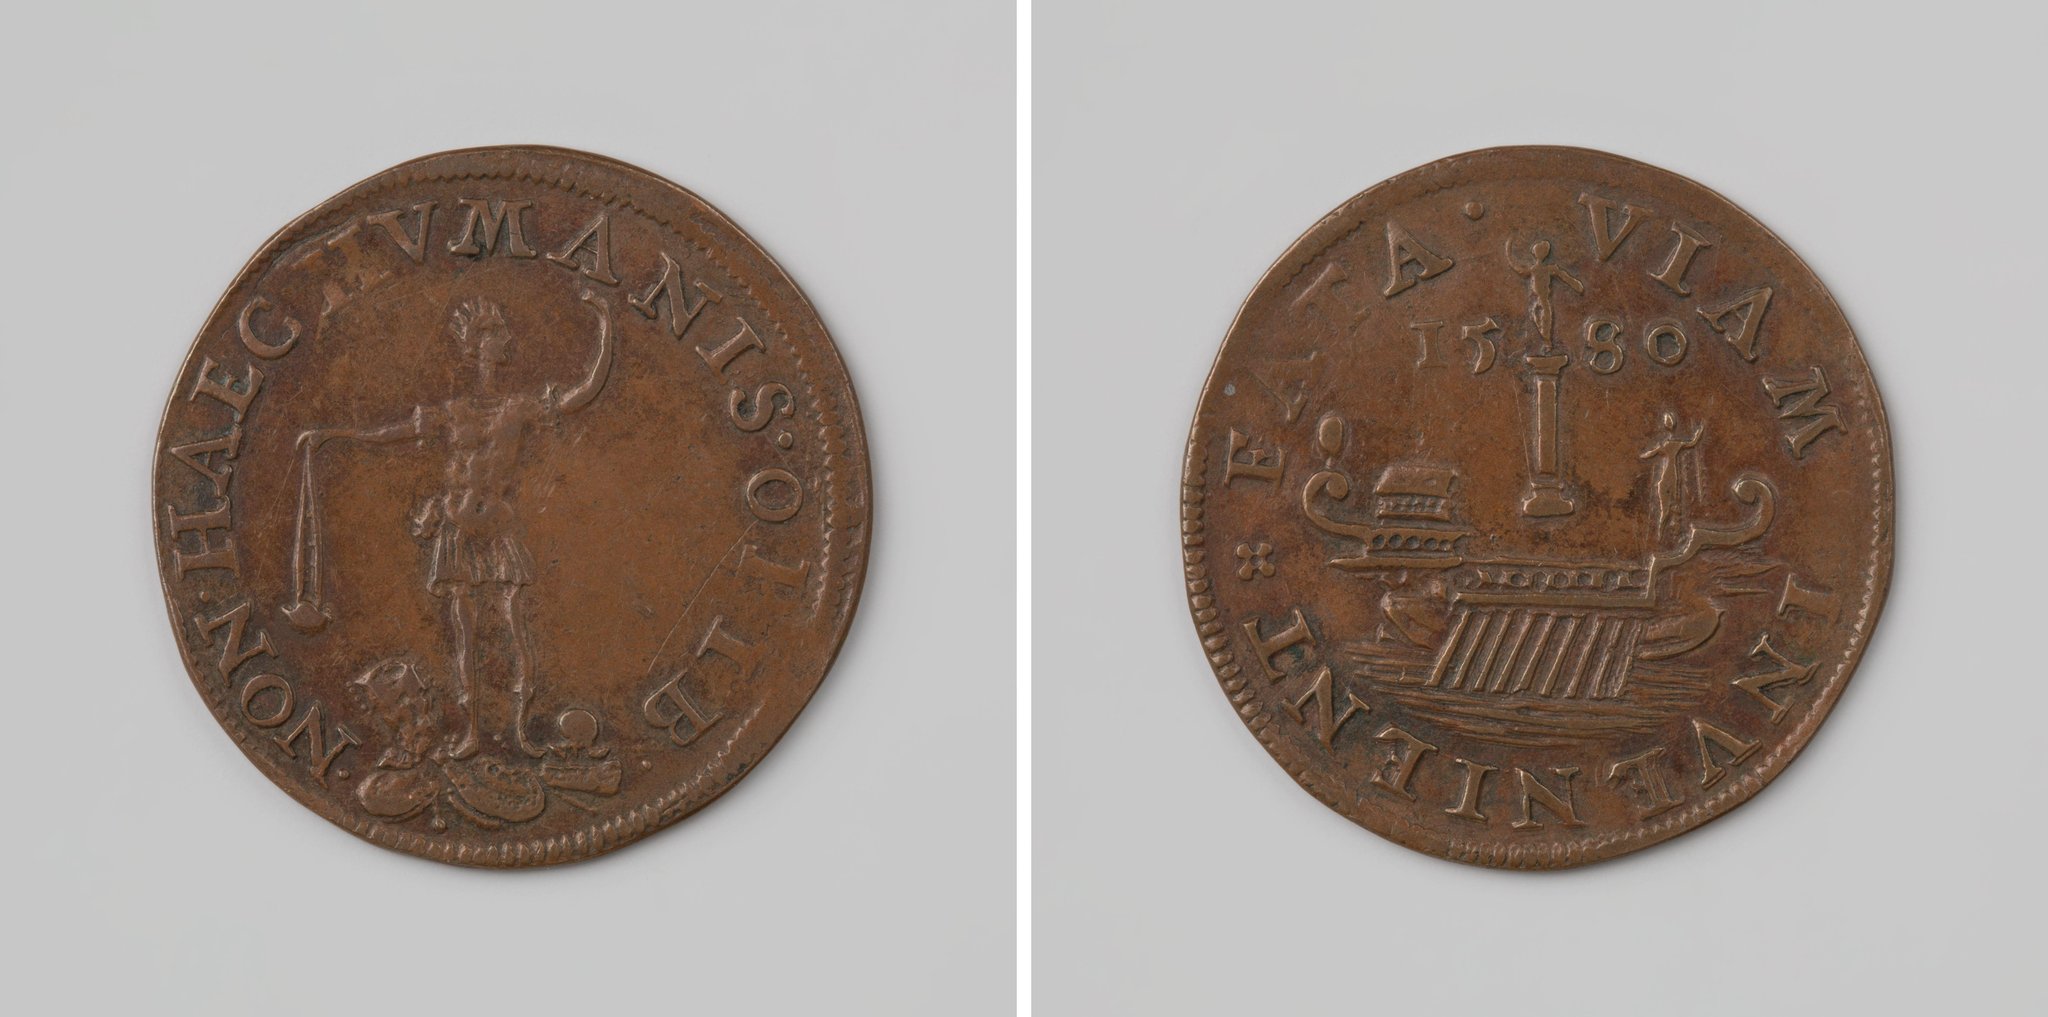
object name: jeton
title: Allegorie op de aanbieding van het stadhouderschap over Holland, Zeeland en Utrecht aan Willem I, prins van Oranje-Nassau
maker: Anonymous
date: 1580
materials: copper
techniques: striking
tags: delft, william i (prince of orange), zeeland, utrecht, holland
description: Koperen penning. Voorzijde: David met slinger in hand, staande tussen gedeelten van wapenrusting van Goliath. Keerzijde: galei, waarop tussen jaartal zegeteken staat binnen omschrift